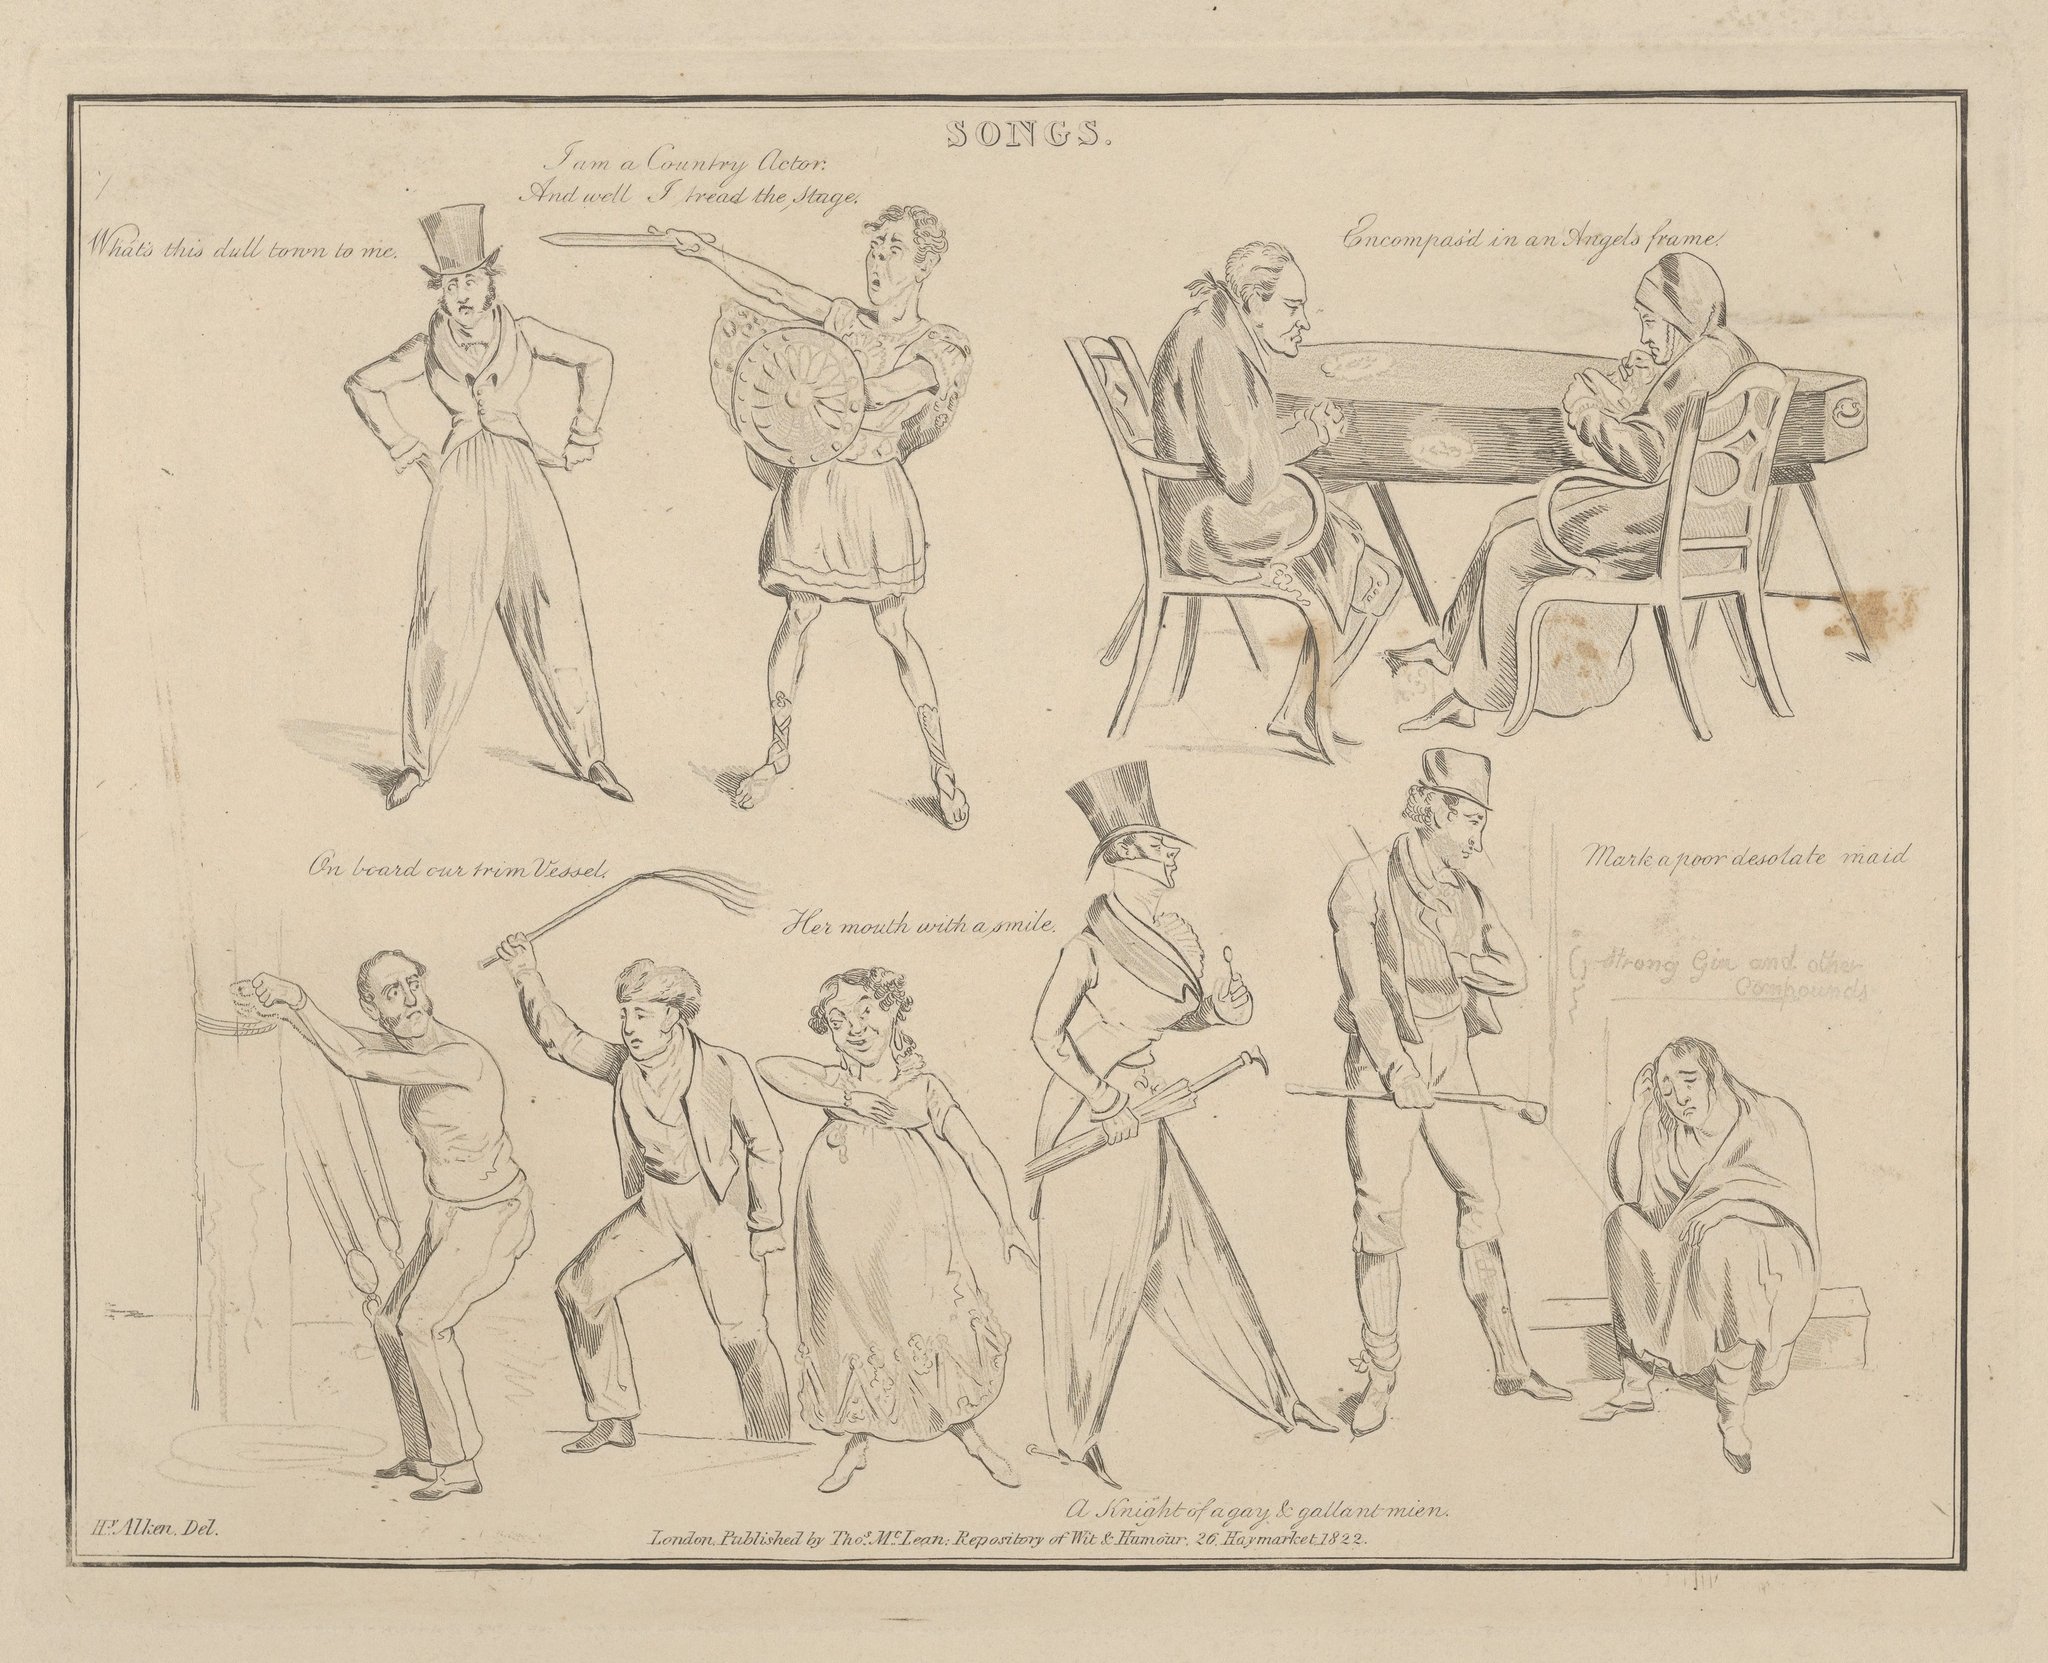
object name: print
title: Songs: "What's this dull town to me..."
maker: henry alken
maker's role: artist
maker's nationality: british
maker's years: 1785-1851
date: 1822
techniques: etching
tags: shields,swords,men,women